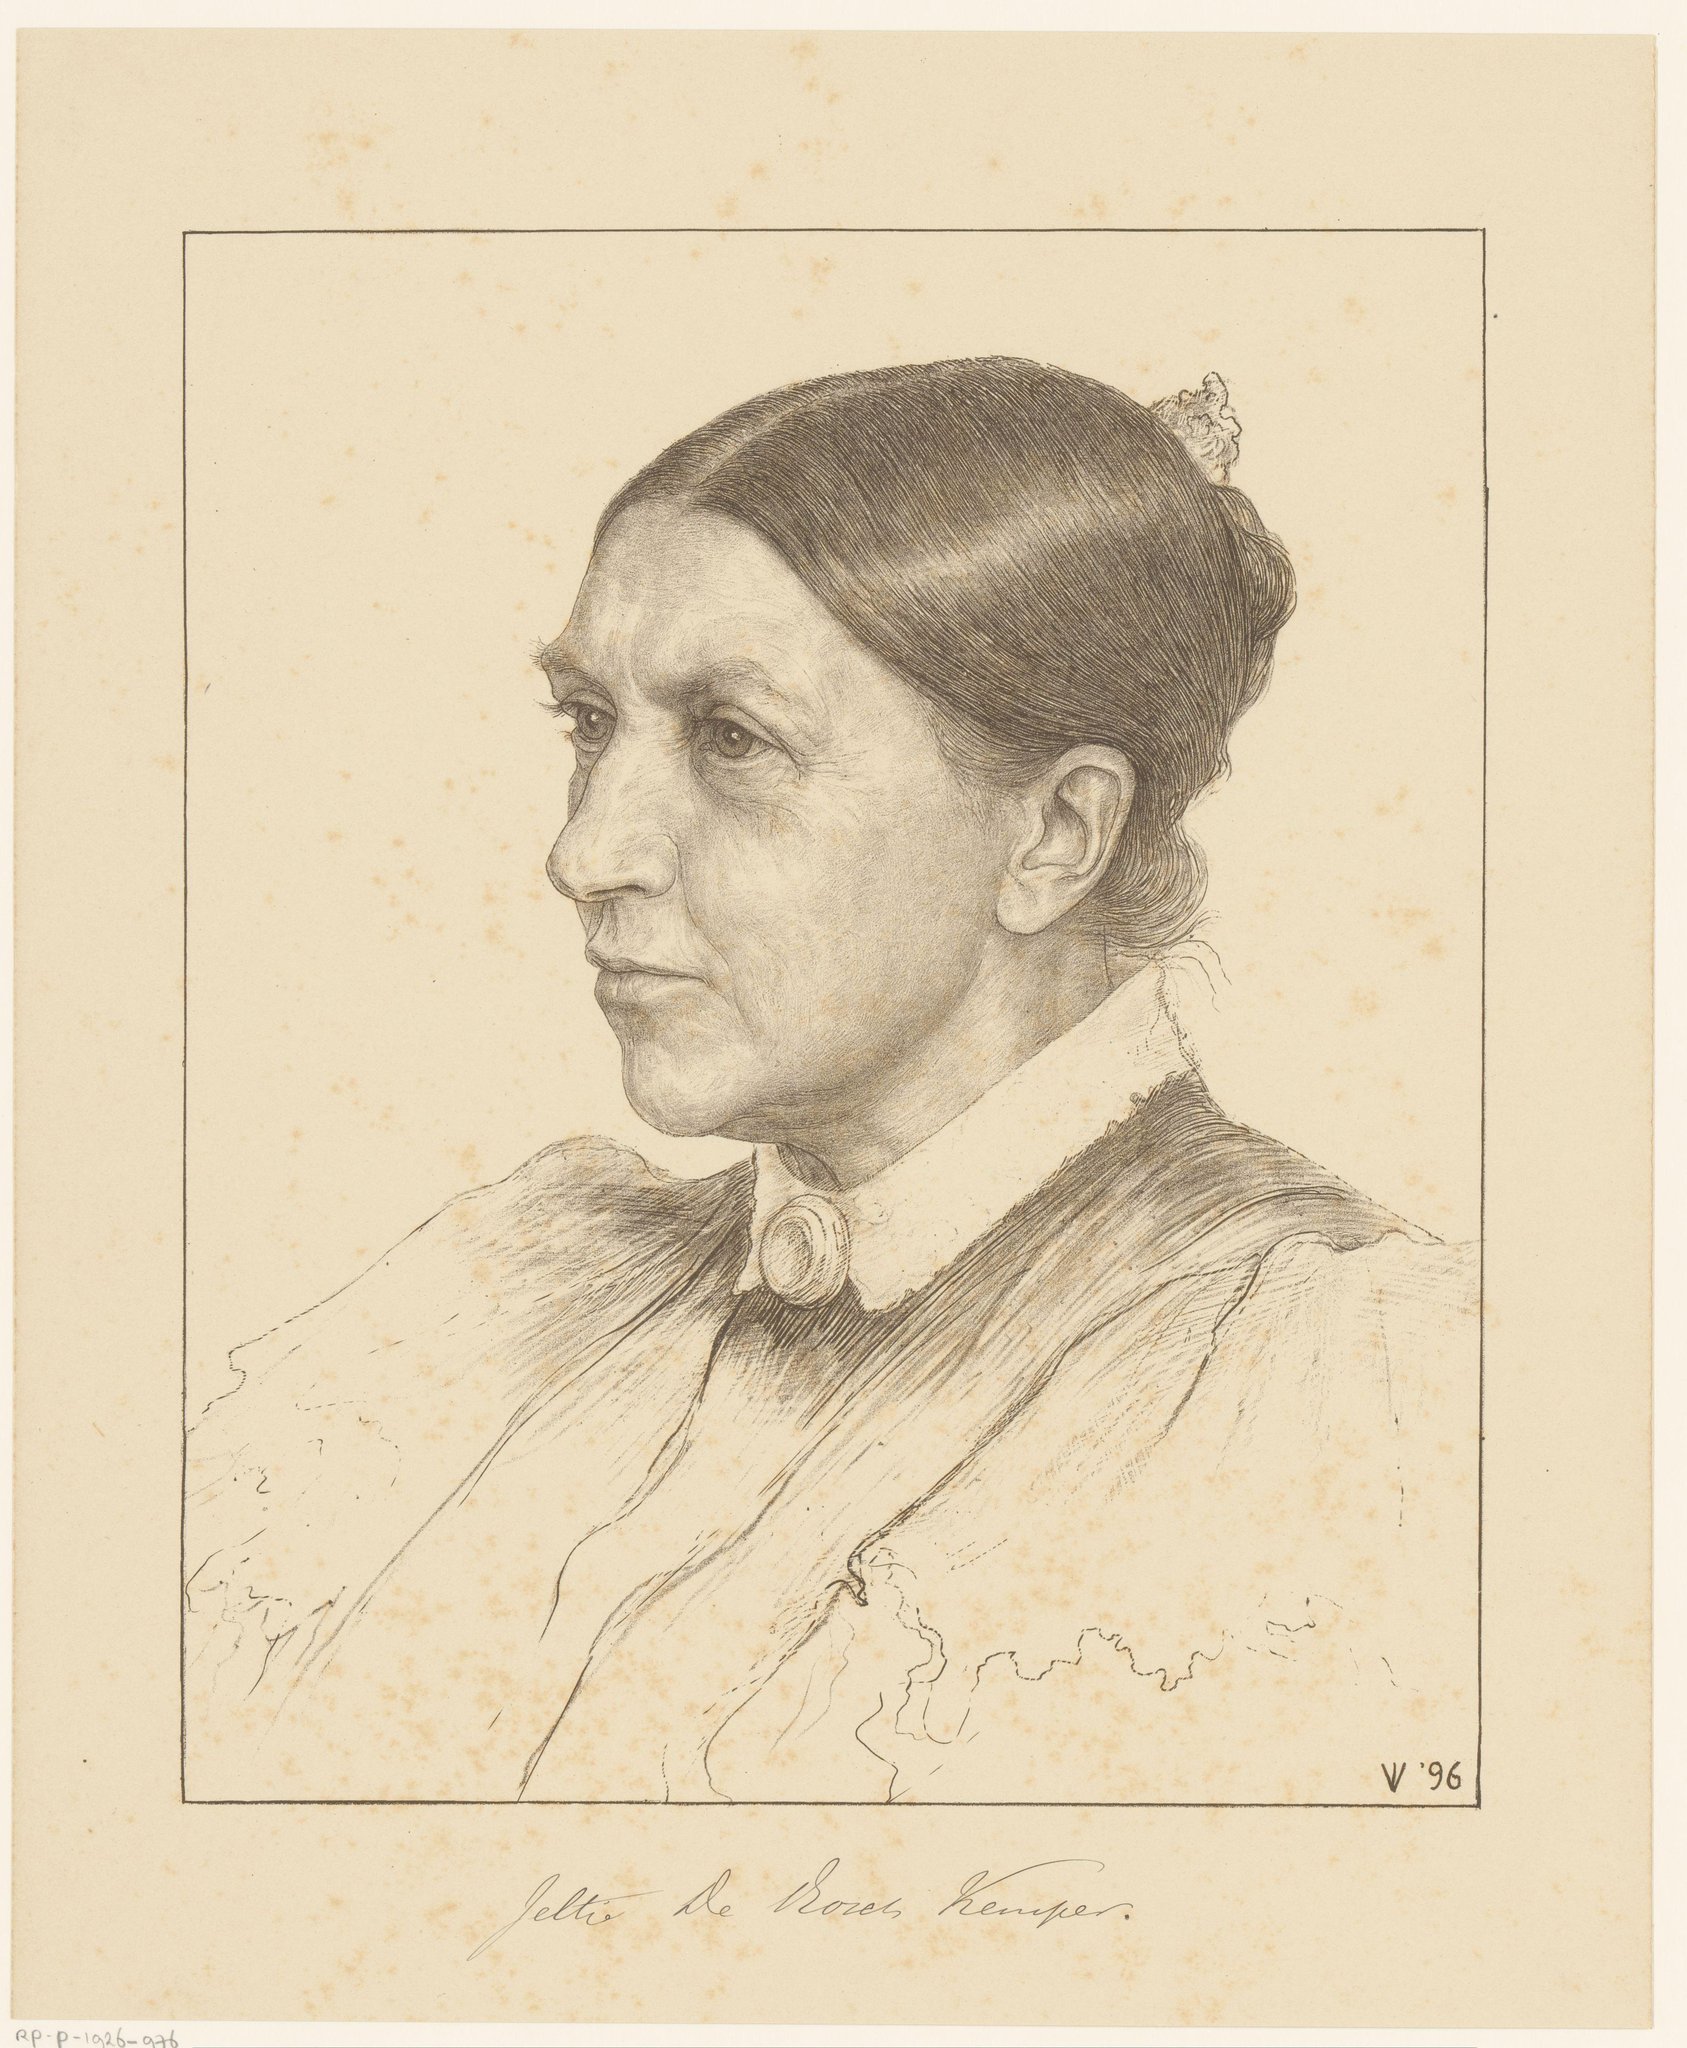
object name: print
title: Bekende tijdgenooten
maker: jan veth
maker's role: designer, draughtsman, painter, print maker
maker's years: 1864-1925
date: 1896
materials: paper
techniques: lithograph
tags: amsterdam, historical persons - bb - woman (+ (full) bust portrait)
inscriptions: signature: ‘Jeltje de Bosch Kemper’, inscription: Lugt 2228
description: Deze prent werd uitgegeven door De Amsterdammer op 8 november 1896.